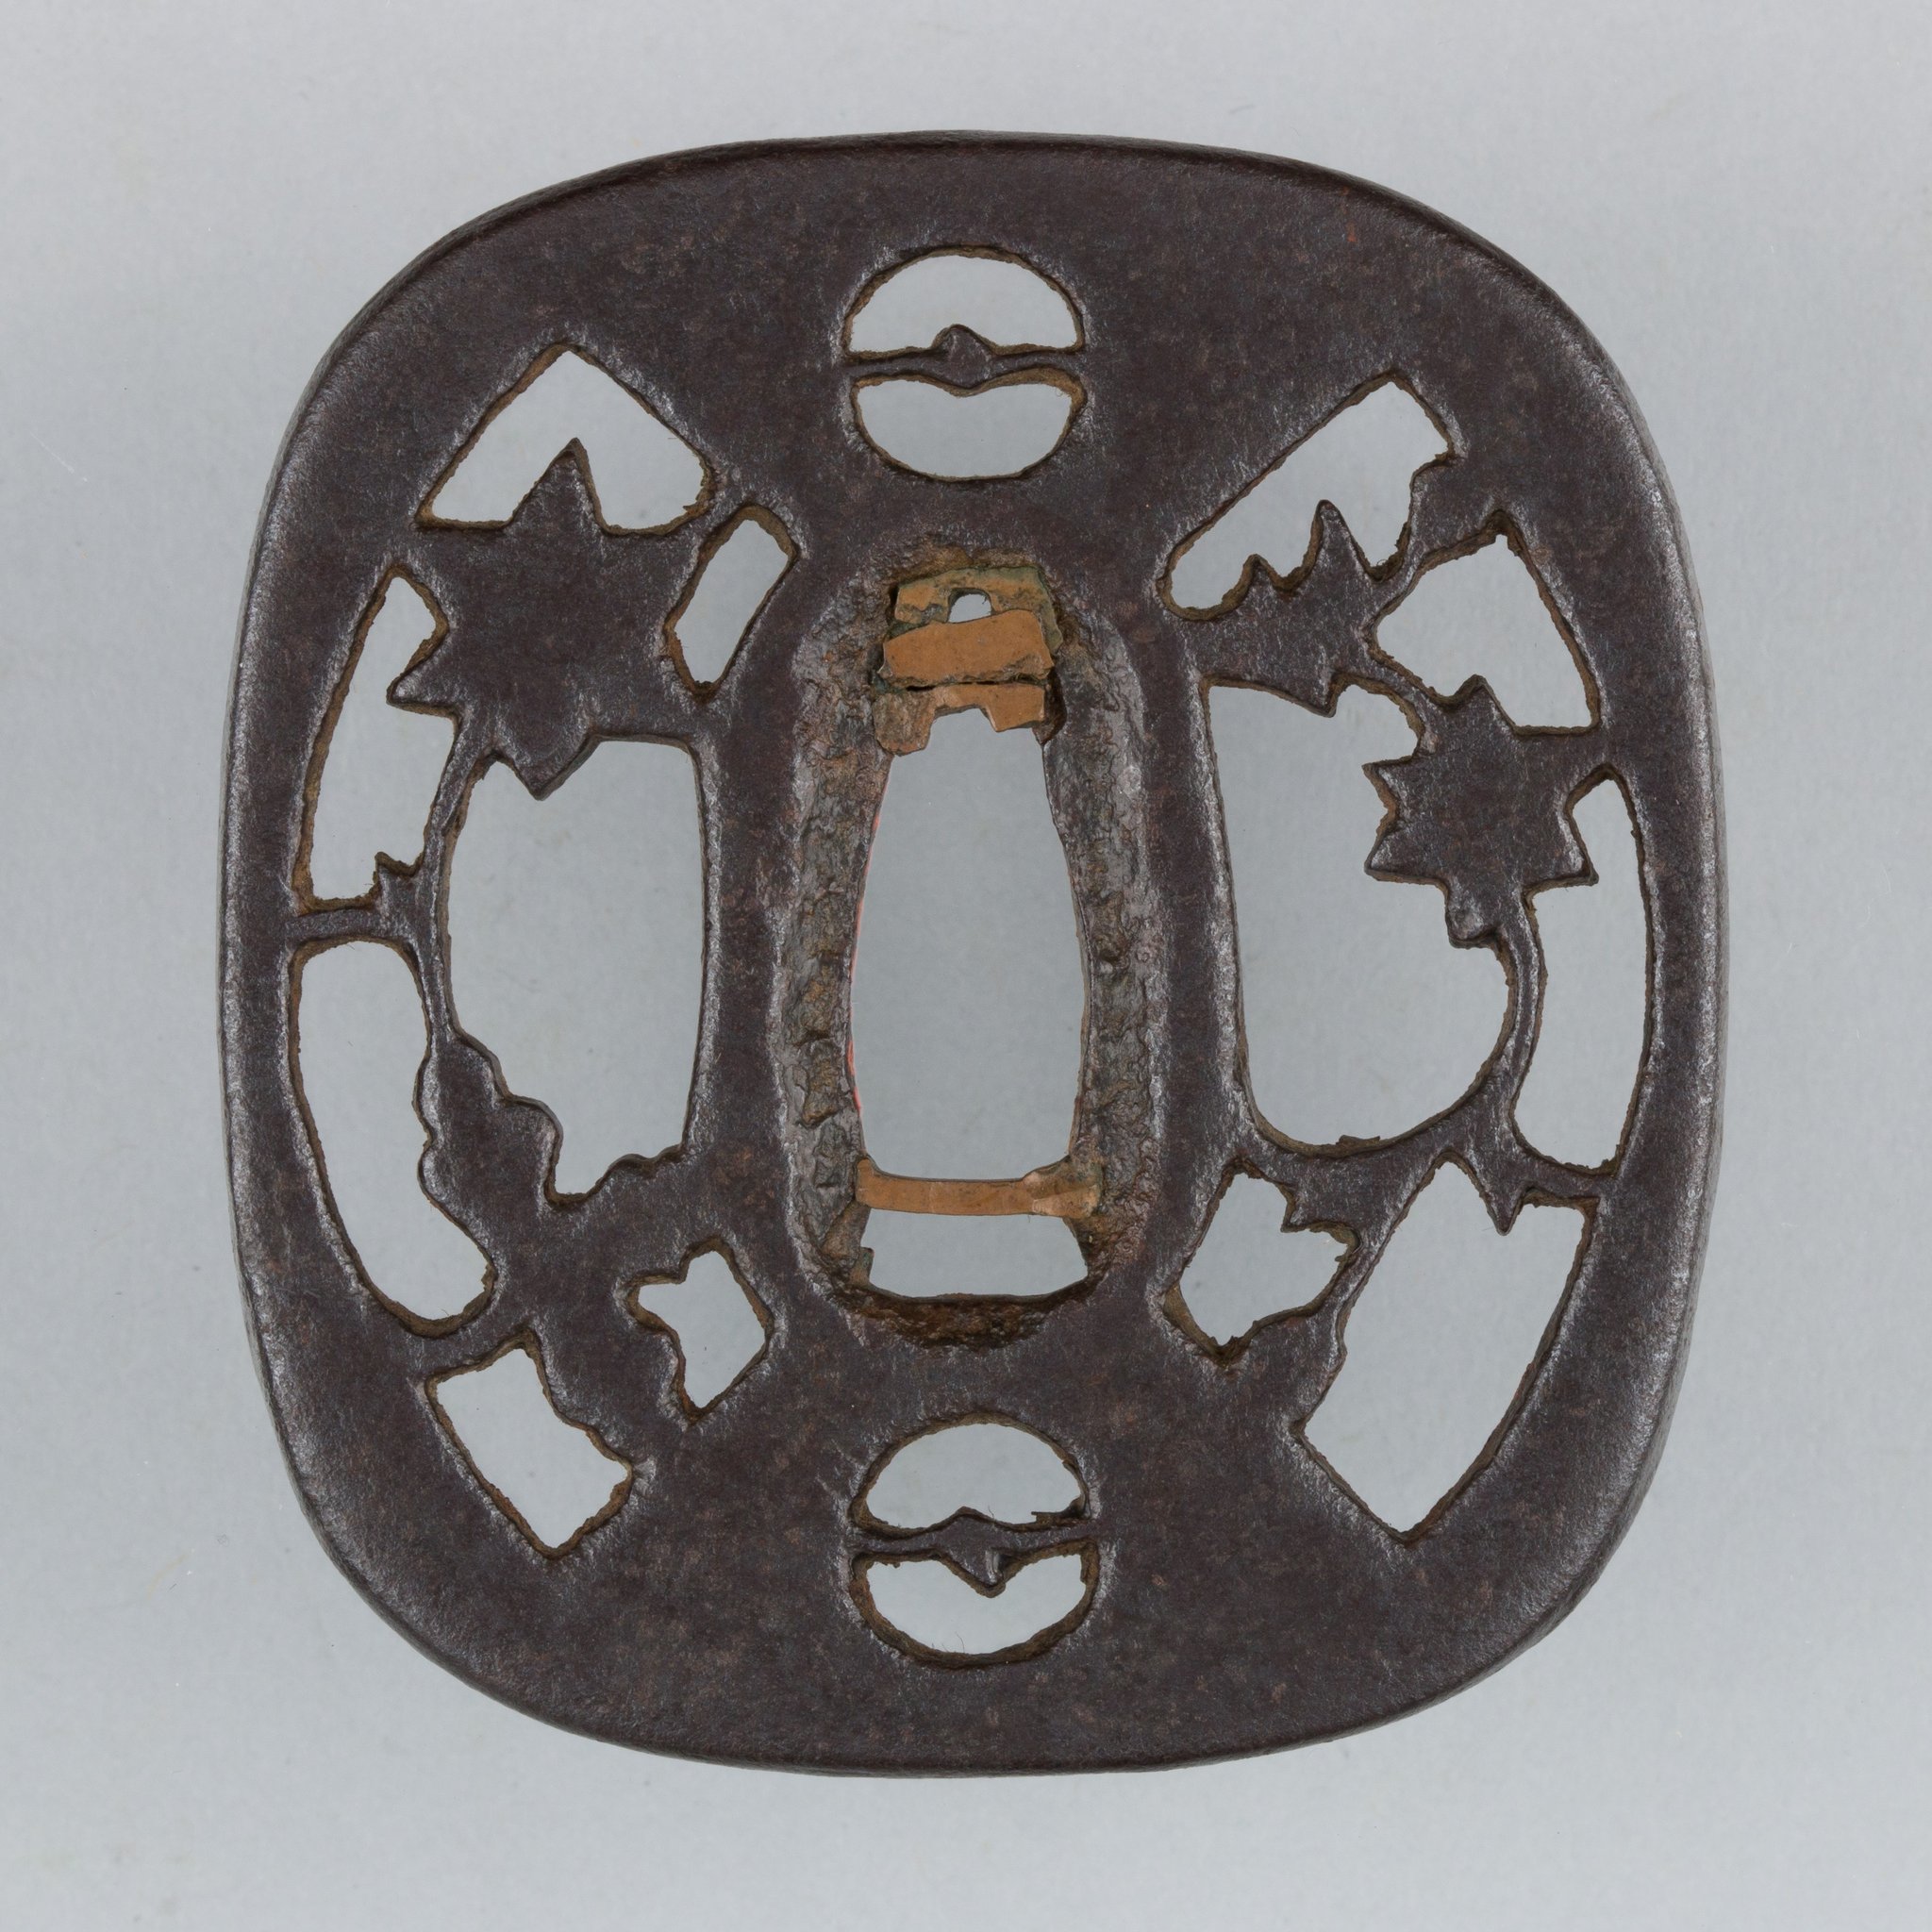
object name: sword guard tsuba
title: Sword Guard (Tsuba)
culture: japanese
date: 1567-1633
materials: copper, iron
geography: japan